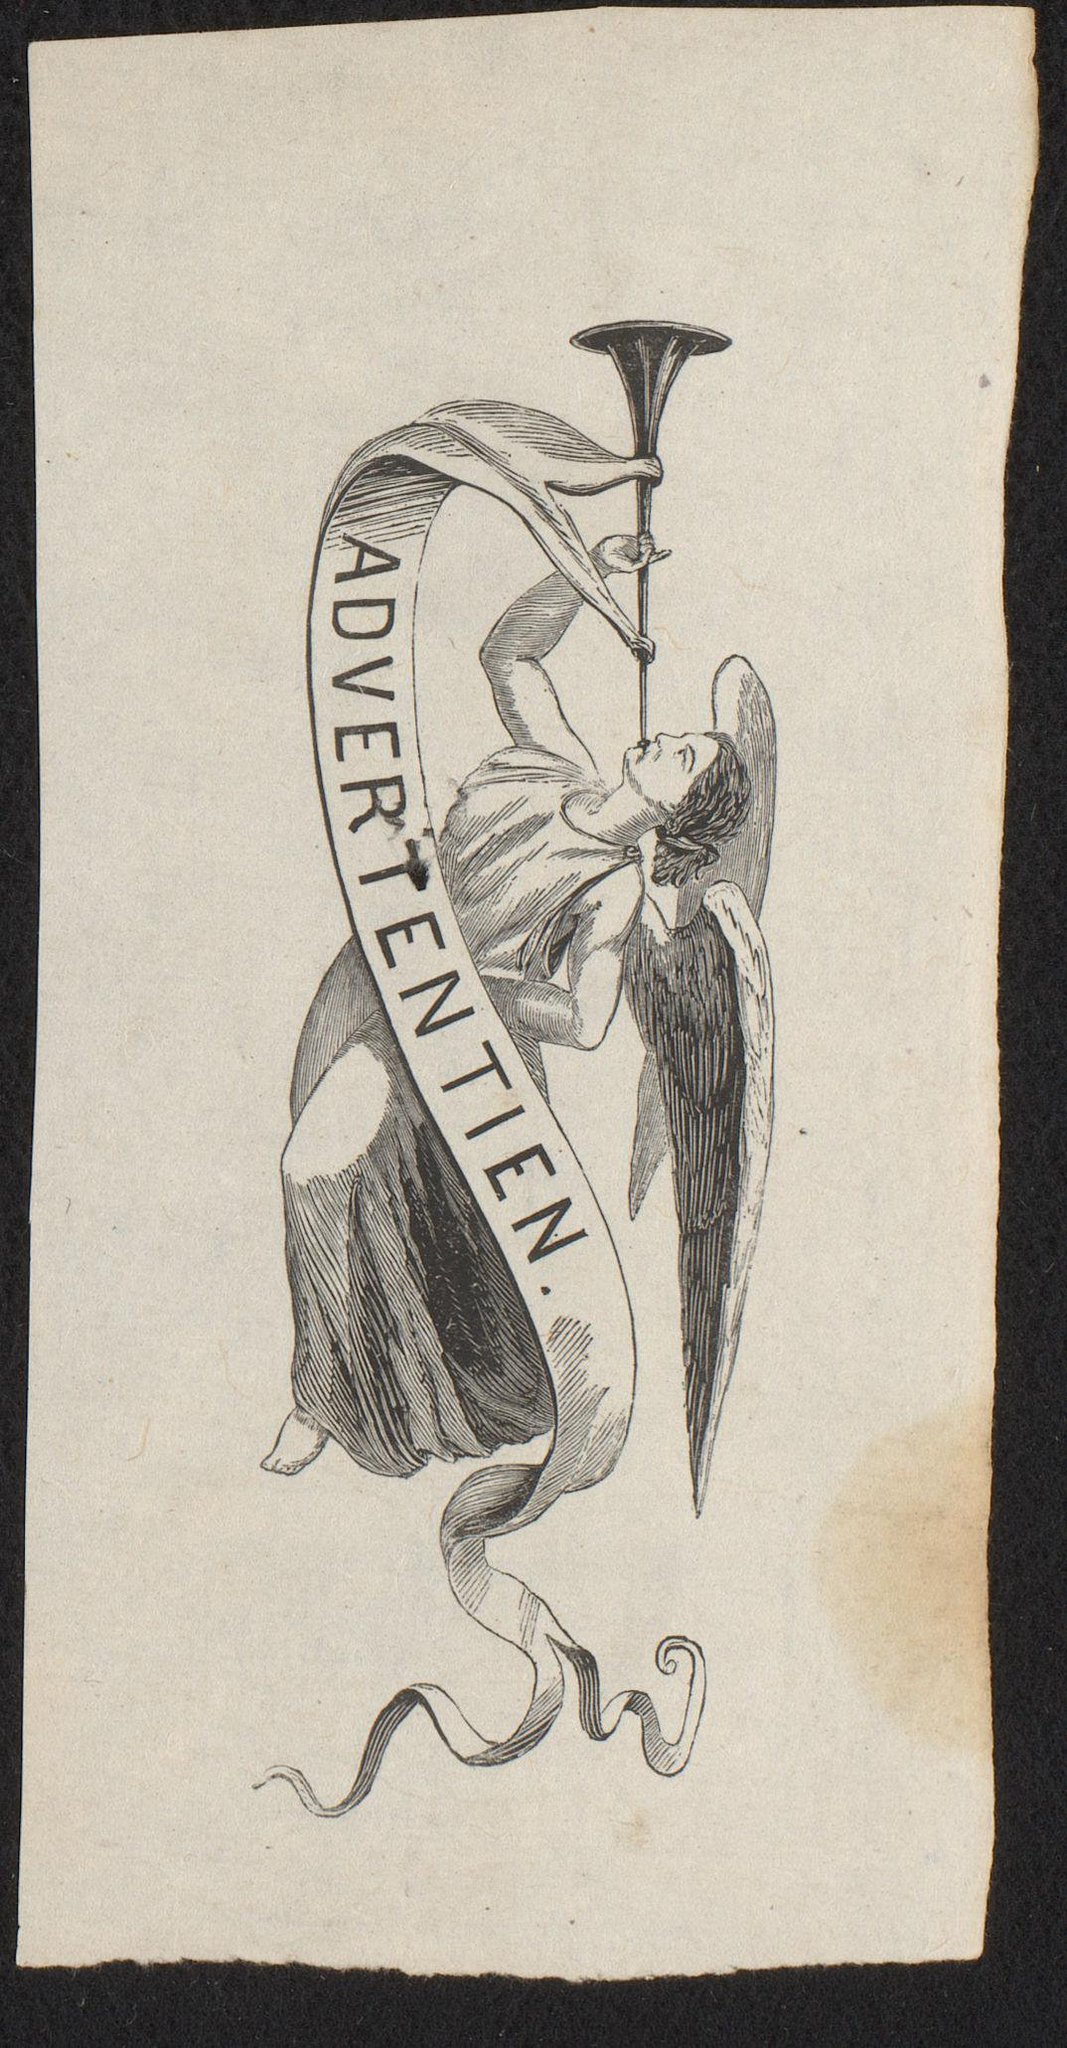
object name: print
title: Titelhoofd 'Advertentien' met een op een bazuin blazende engel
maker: isaac weissenbruch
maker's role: print maker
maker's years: 1826-1912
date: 1836-1912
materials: paper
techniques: engraving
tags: horn, trumpet, cornet, trombone, tuba, herald, angels